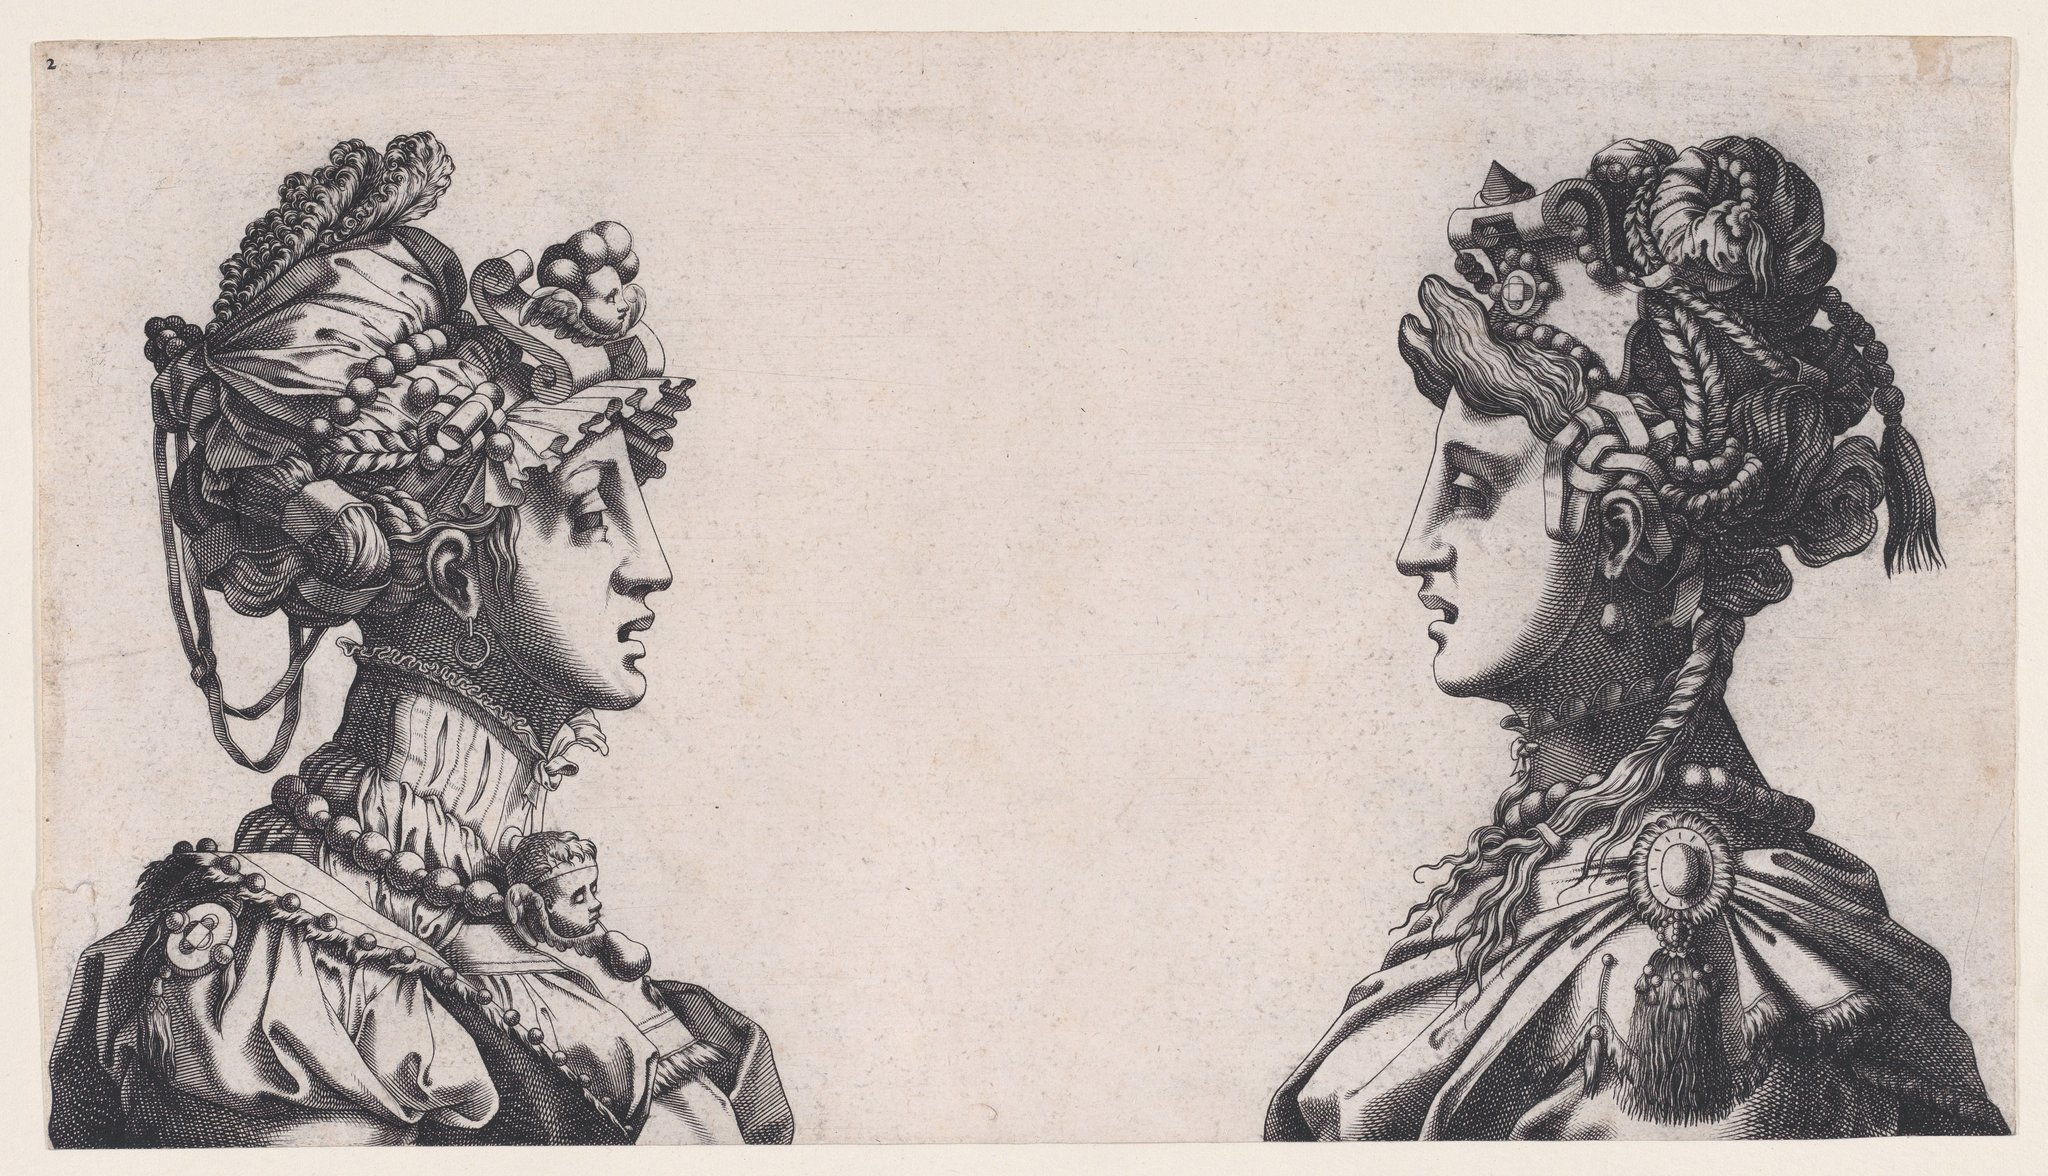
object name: print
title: Fantastical Female Heads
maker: rené boyvin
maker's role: artist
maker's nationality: french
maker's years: 1525-1598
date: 1525-1600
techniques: engraving